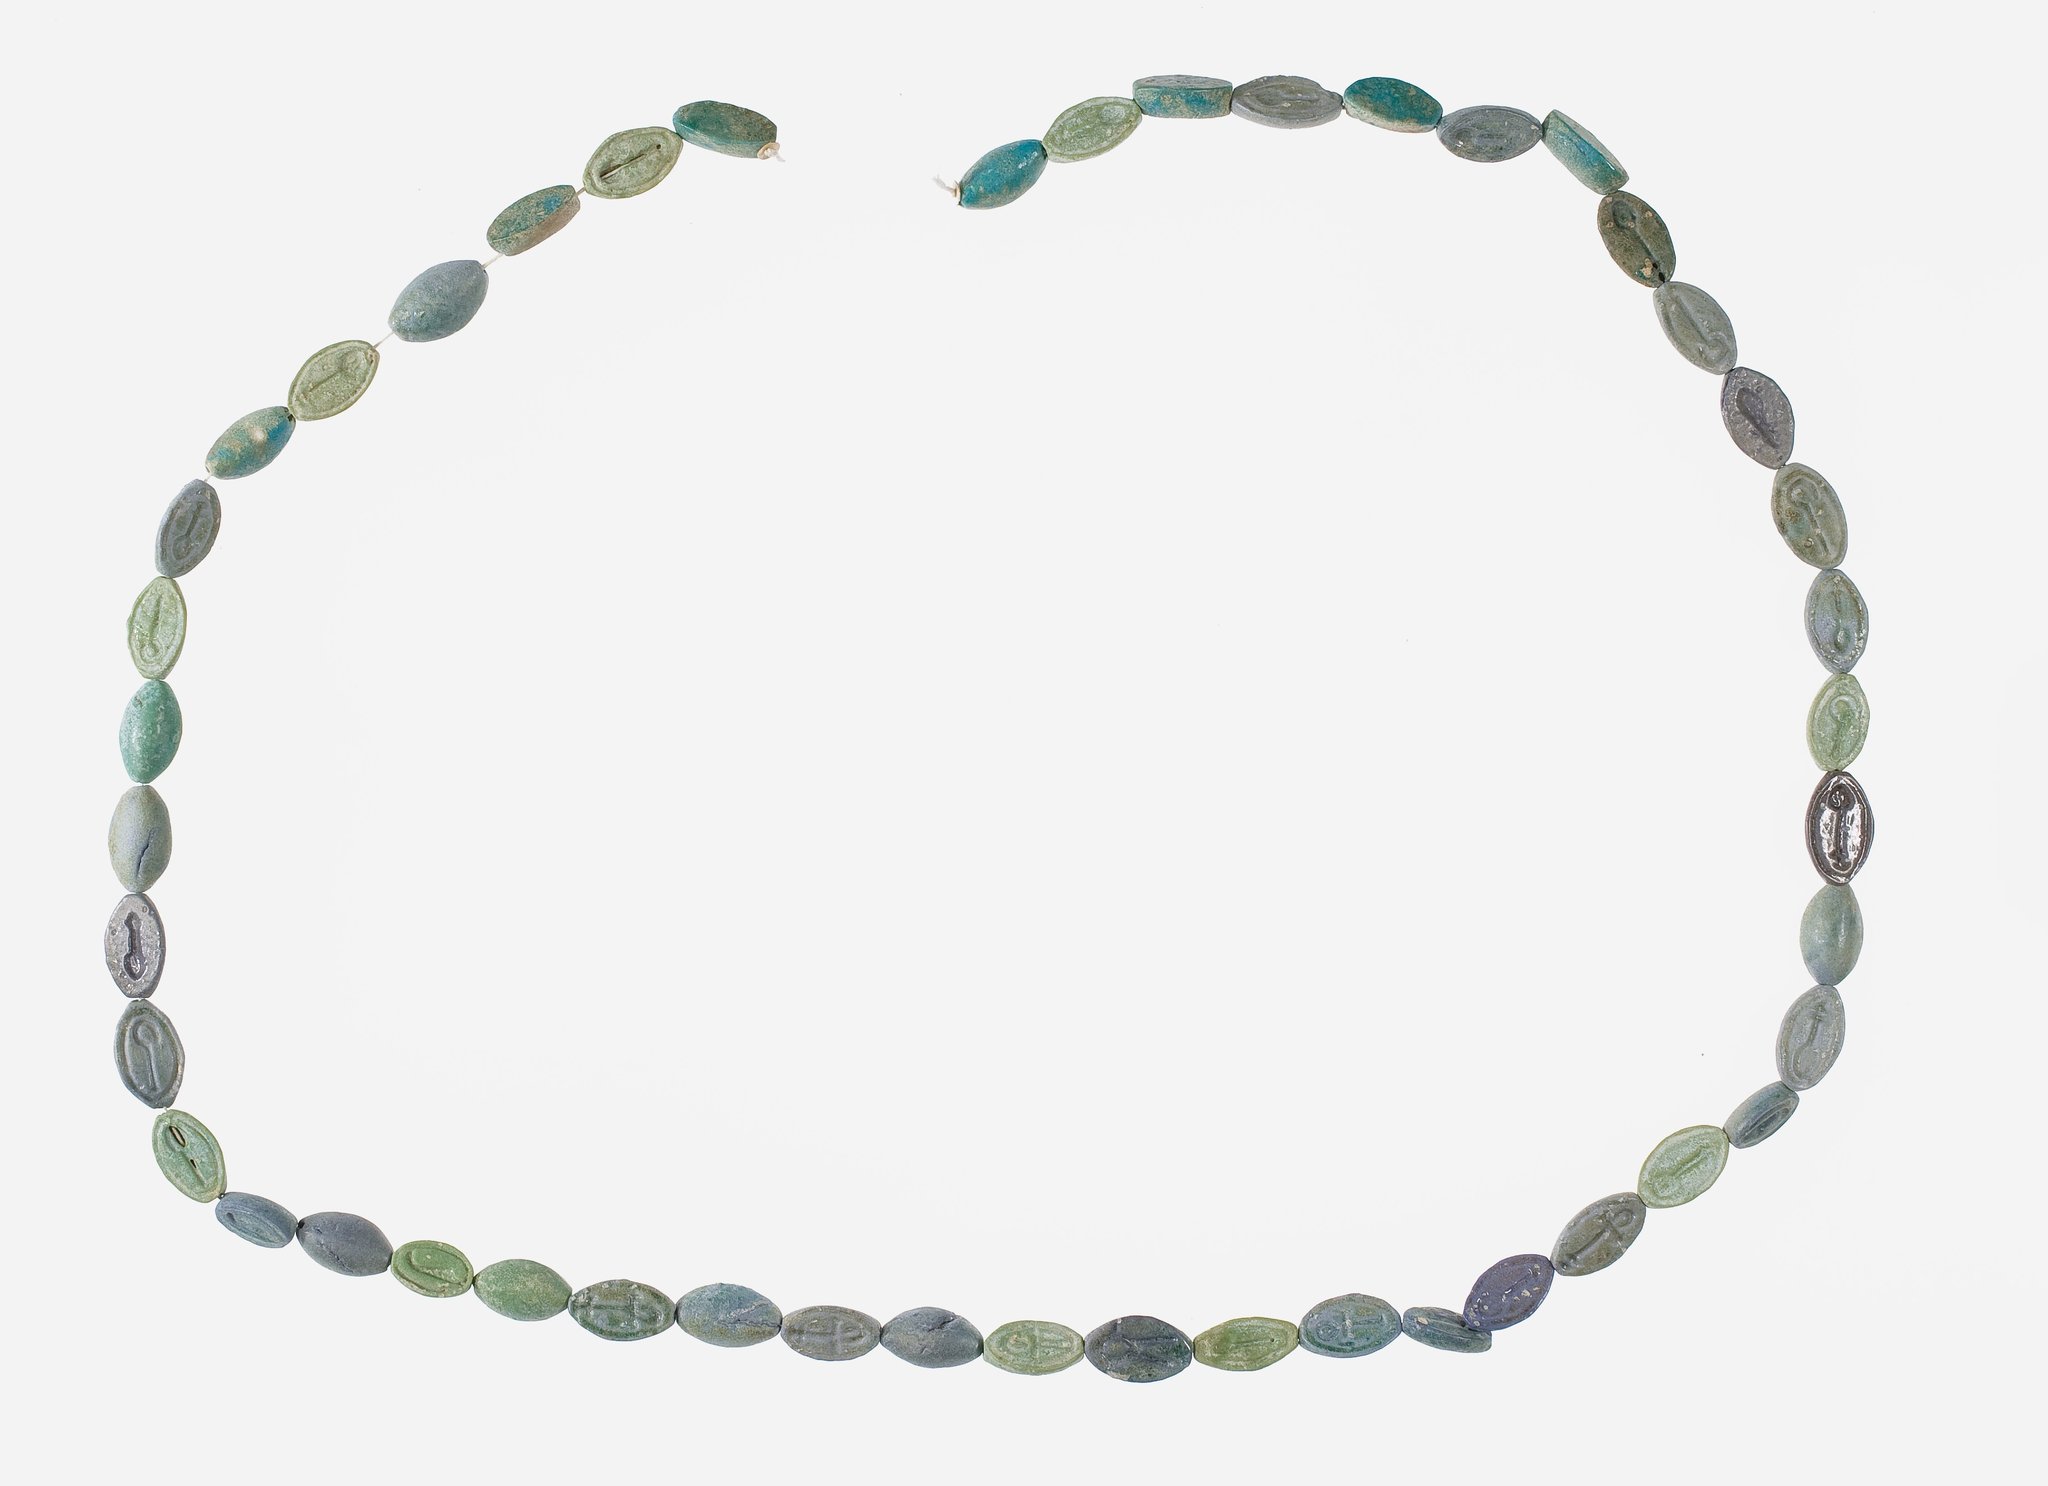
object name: cowroids 46, nefer, heka, maat, ankh, sa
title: String of 46 Cowroids Inscribed with Various Hieroglyphs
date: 1390-1352 BCE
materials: faience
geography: egypt